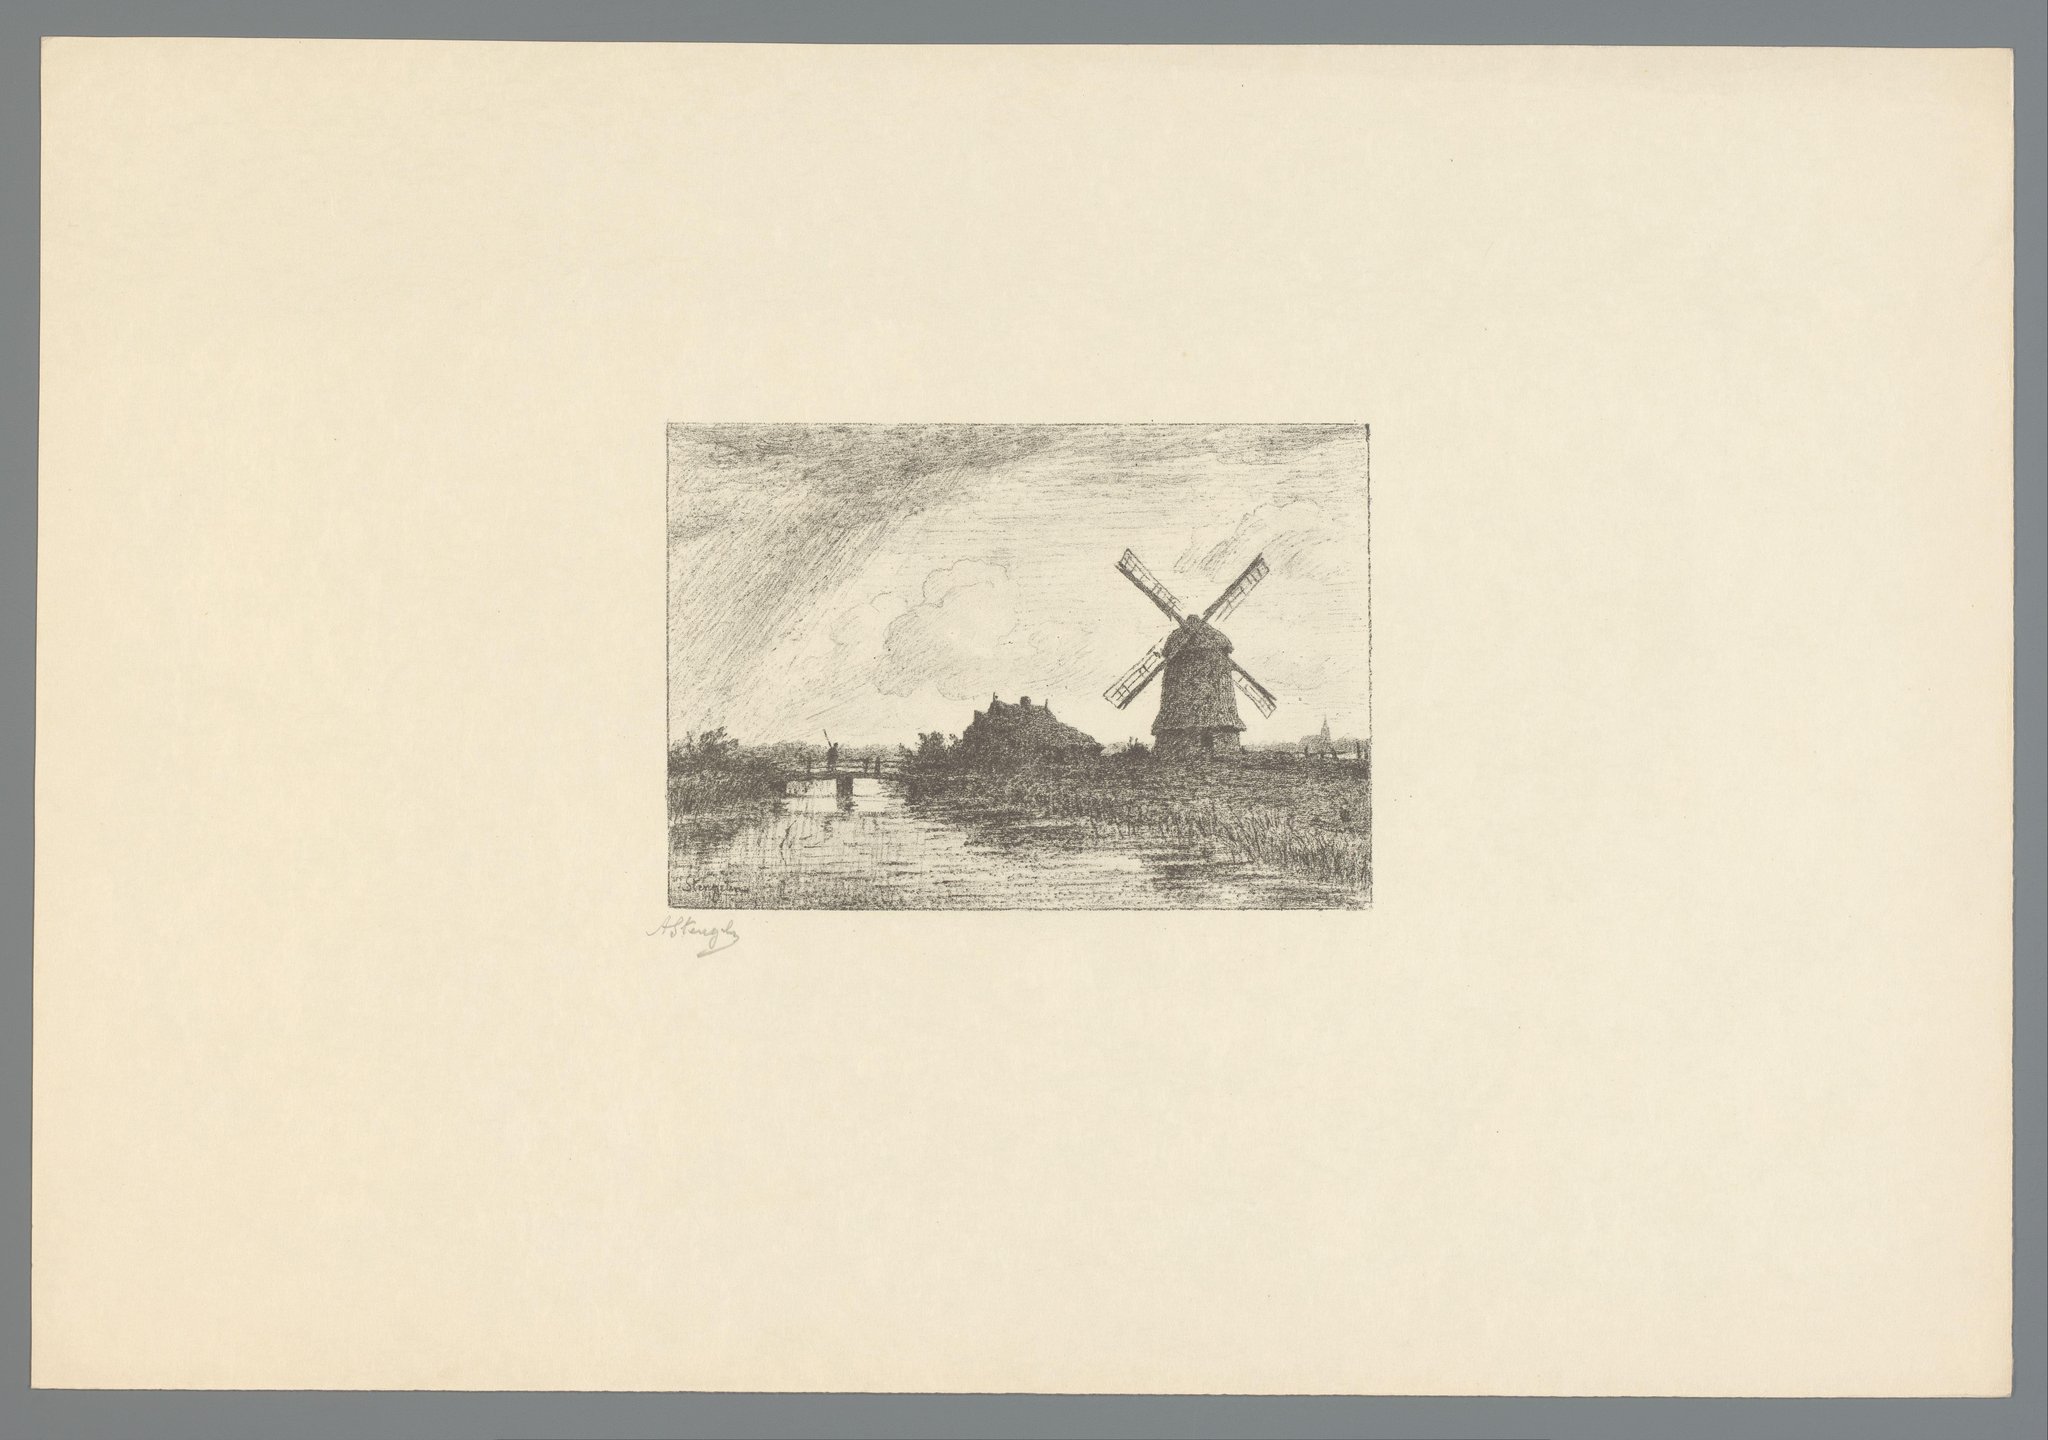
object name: print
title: Molen aan een vaart bij Alkmaar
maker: alphonse stengelin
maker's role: painter, print maker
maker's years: 1852-1938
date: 1876-1910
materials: paper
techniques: lithograph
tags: canal, windmill in landscape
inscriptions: collector's mark: Lugt 2228